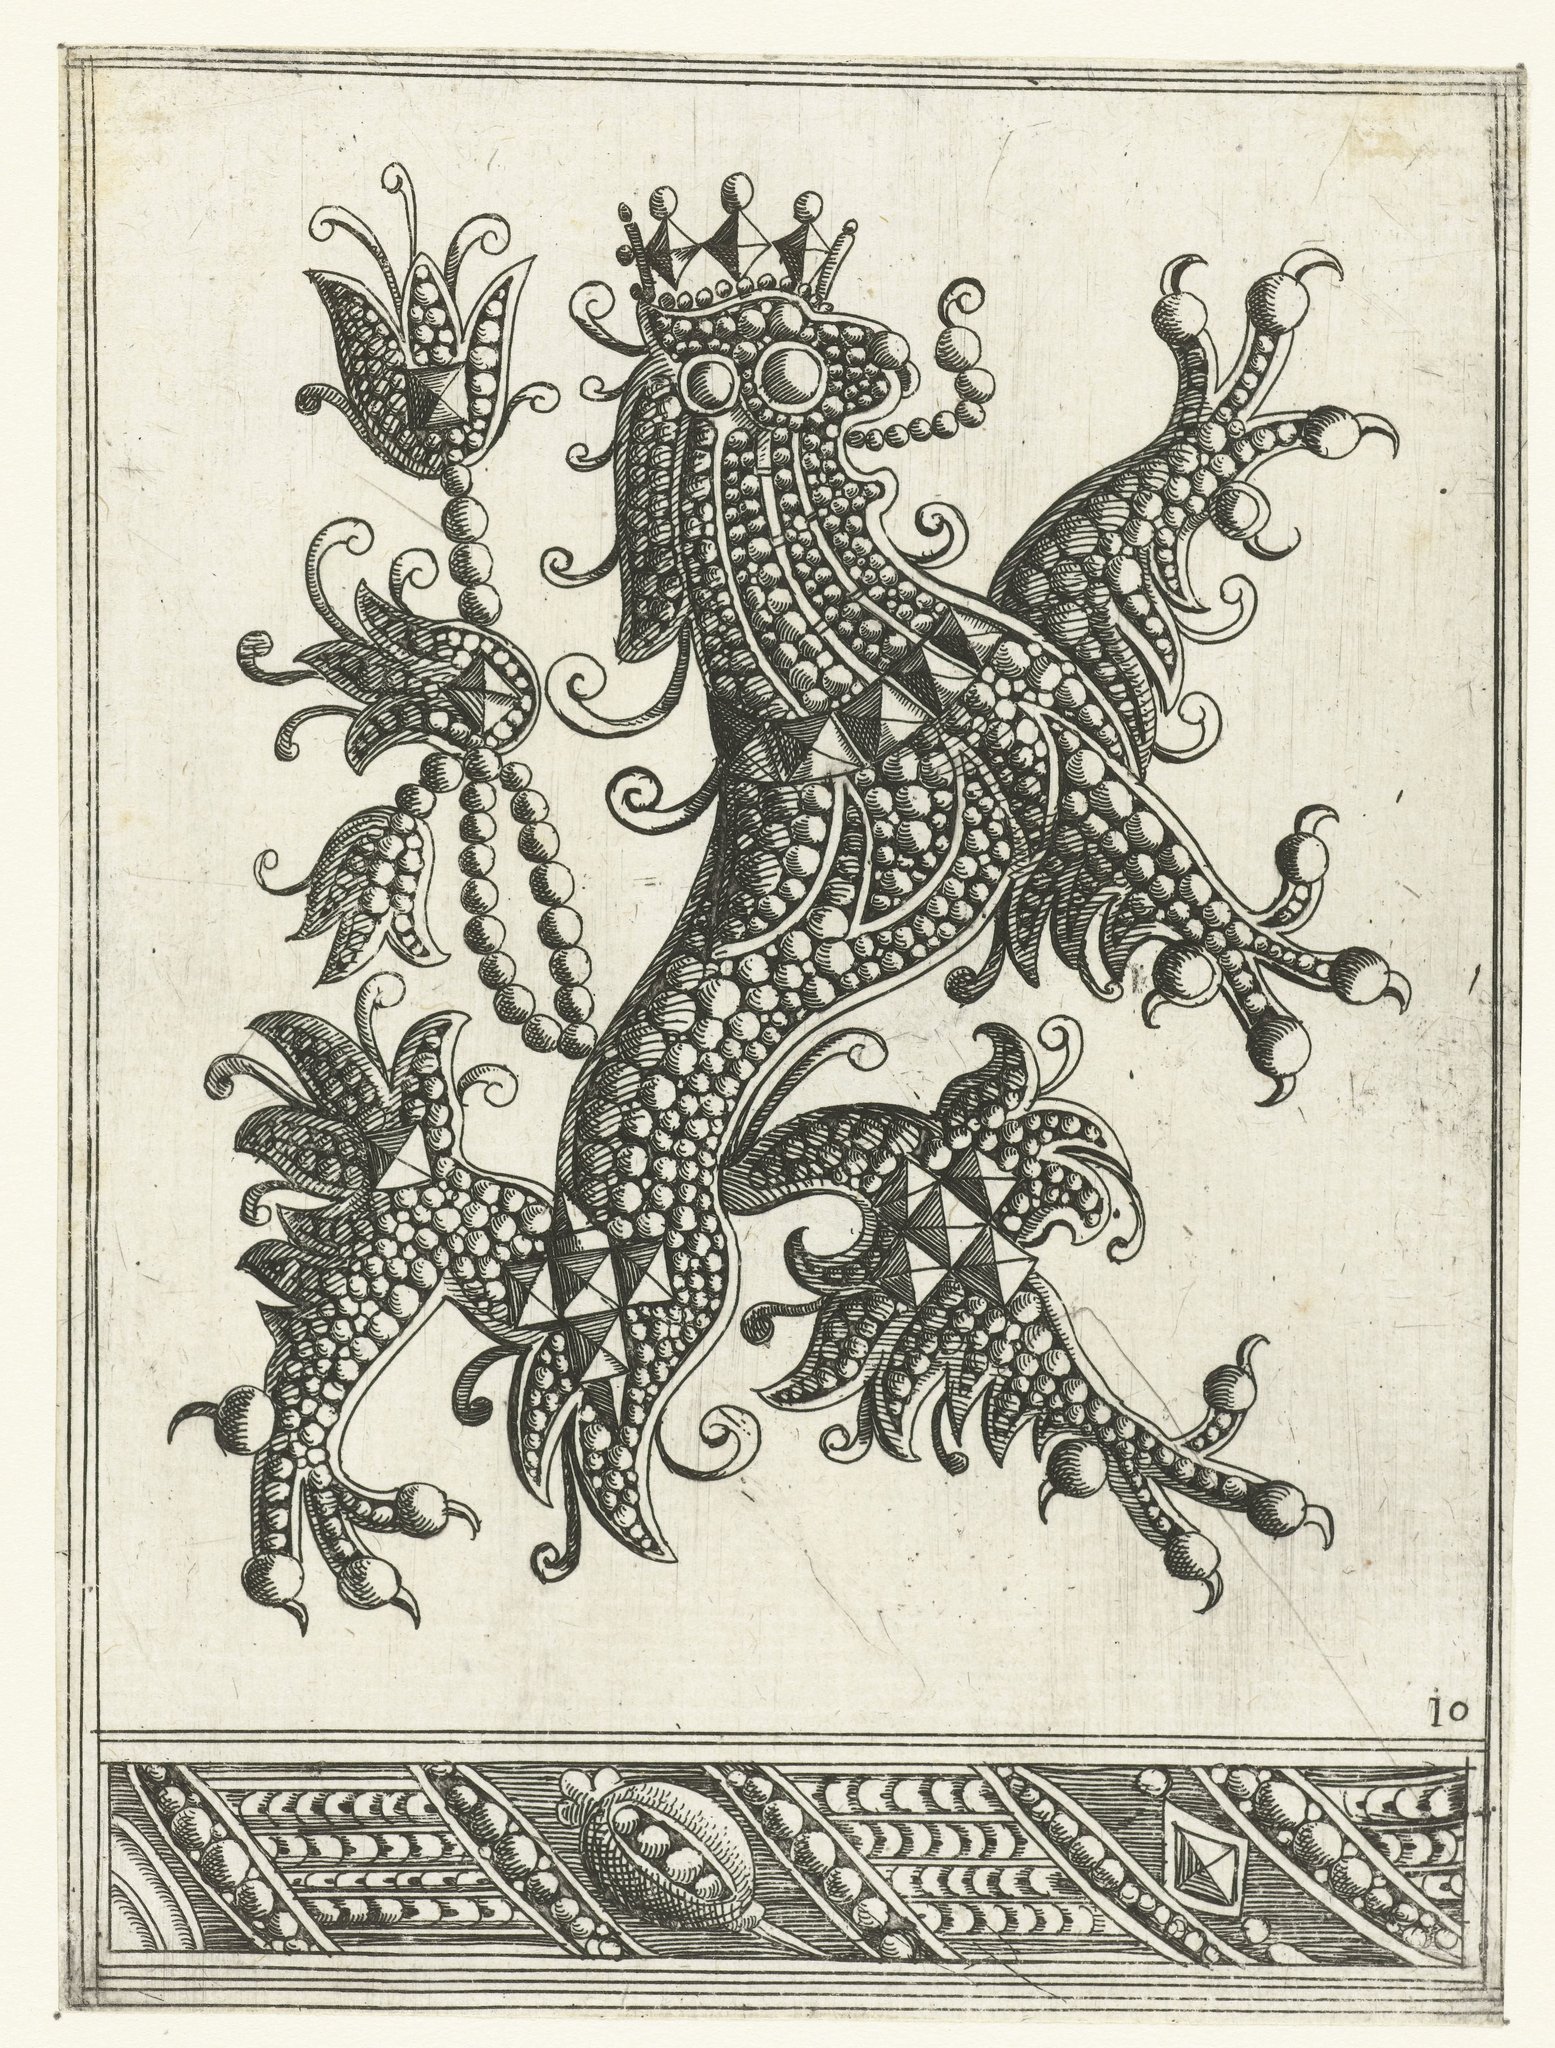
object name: ornament print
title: Voorbeelden voor borduurwerk in goud met edelstenen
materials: paper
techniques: etching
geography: germany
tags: beasts of prey, predatory animals: lion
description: De leeuw draagt een kroon en is afgebeeld boven een rand die eveneens uit edelstenen bestaat.